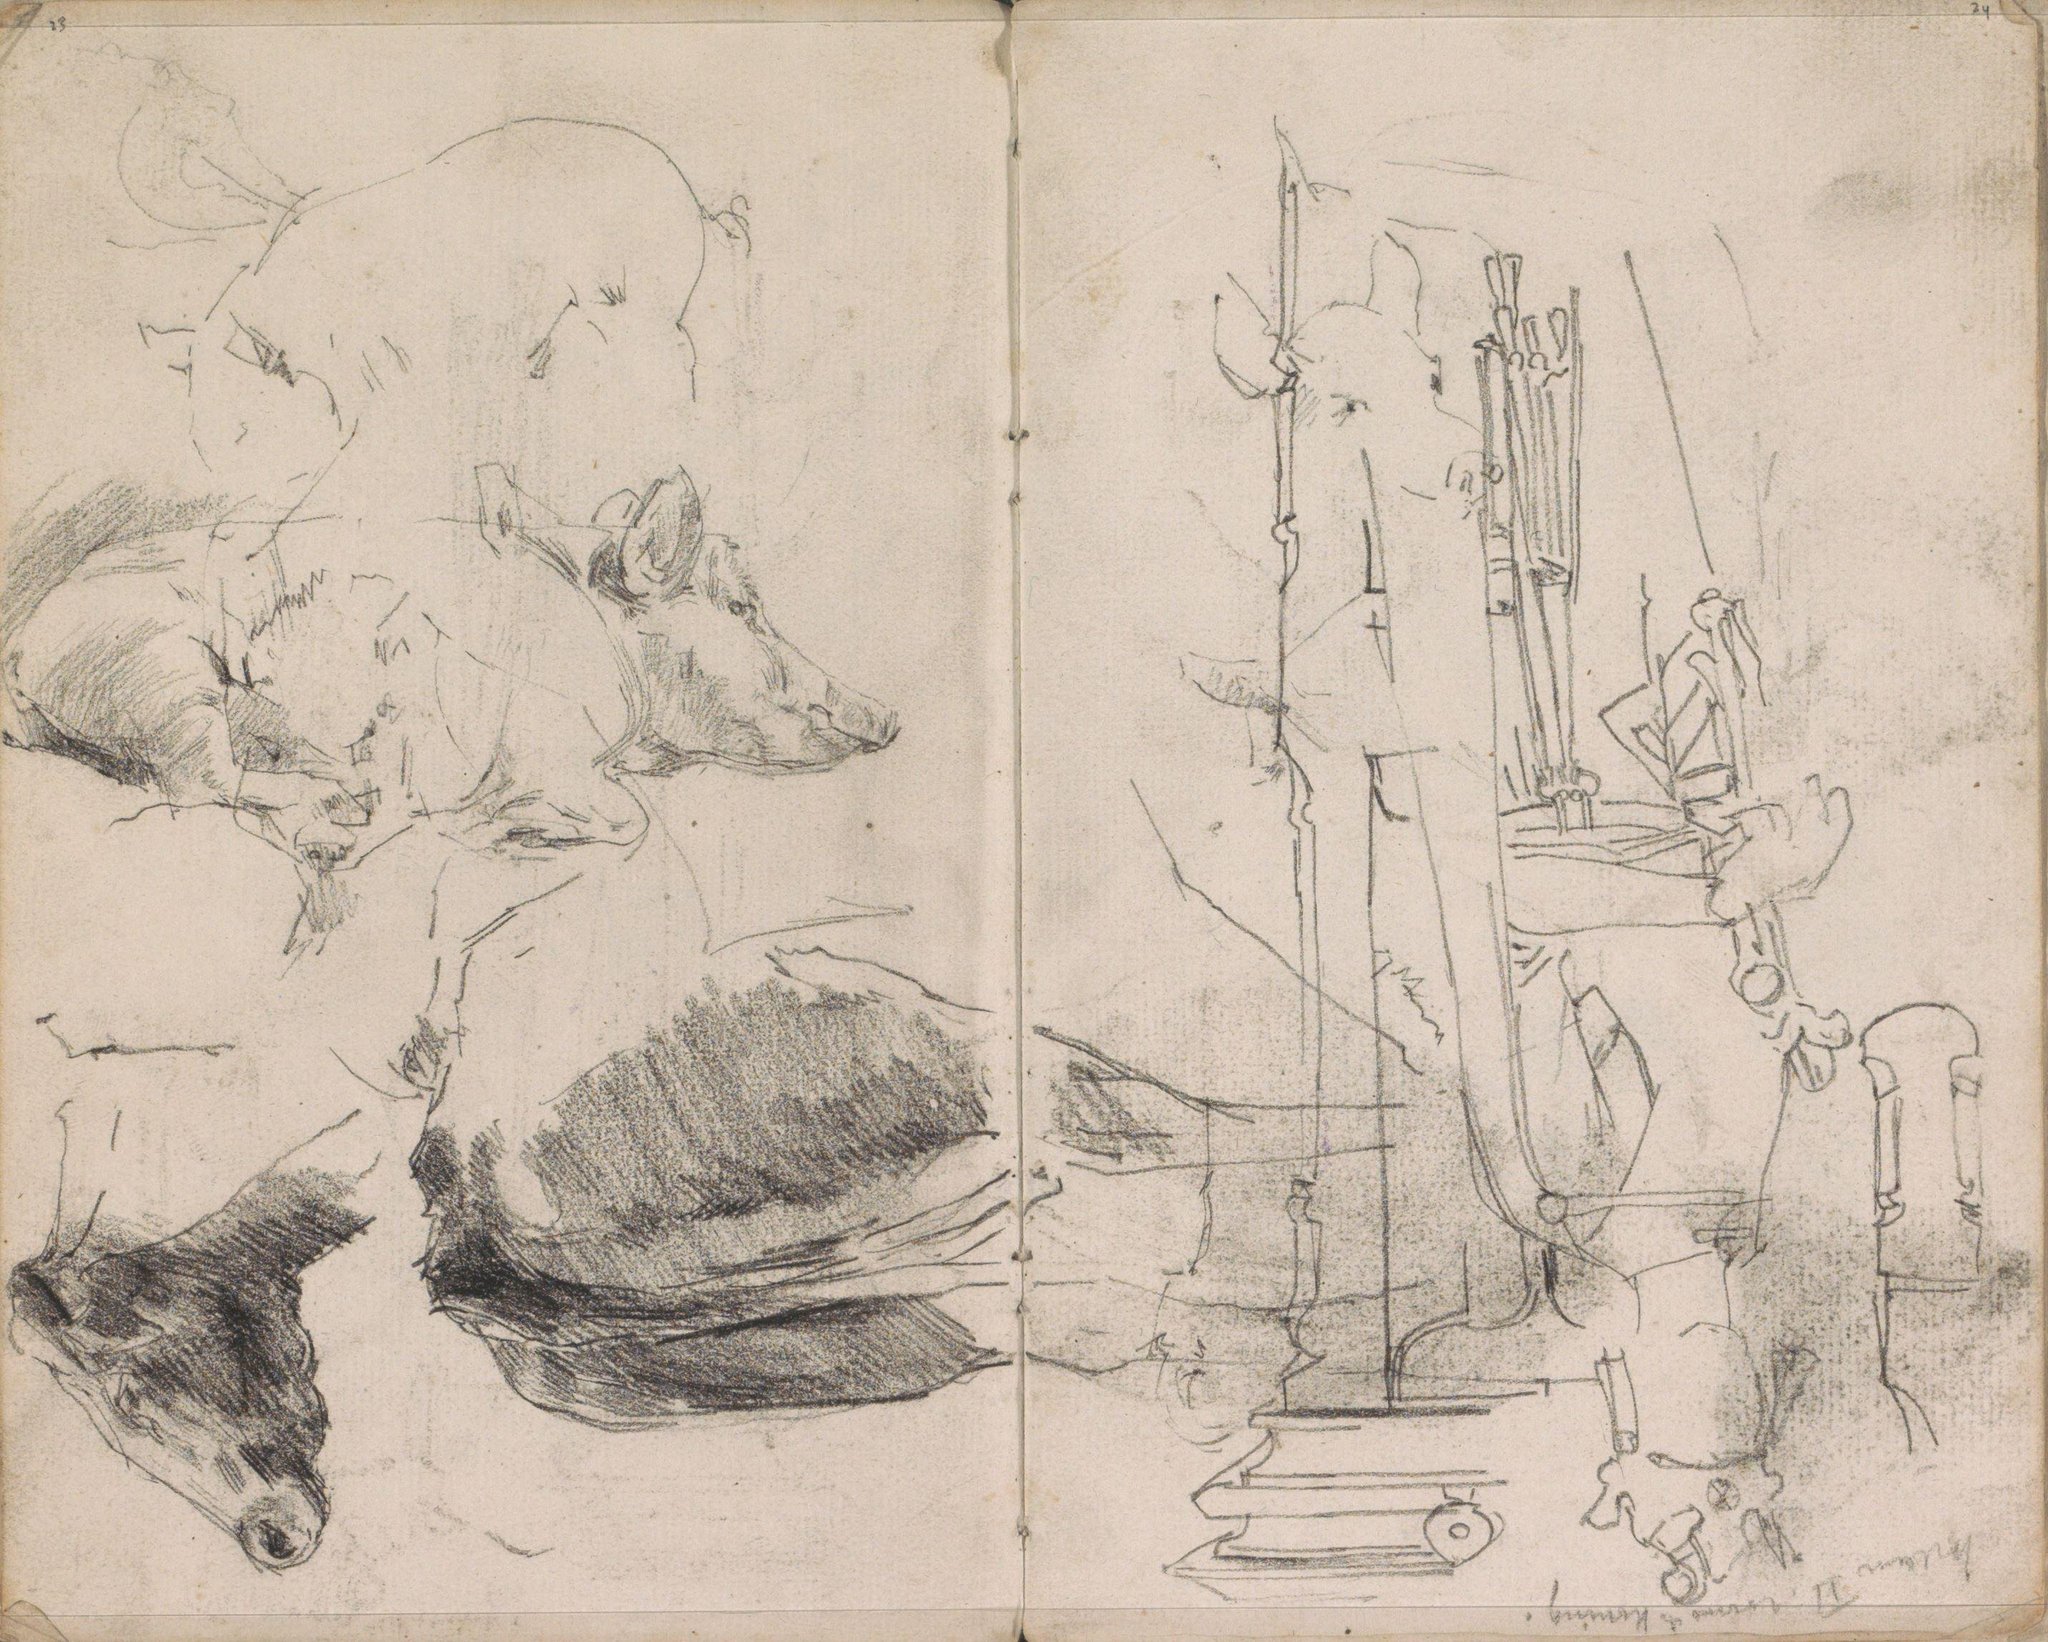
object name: sketchbook leaf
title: Studieblad met varkens, een achterlijf van een koe, architectuurstudies en een studie van Willem II van Holland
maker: george hendrik breitner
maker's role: draughtsman, painter, print maker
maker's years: 1857-1923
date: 1880-1882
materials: chalk, paper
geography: the hague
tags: pig, cow, architectural detail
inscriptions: annotation: ‘Willem II roomsche koning.’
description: Pagina 23 en pagina 24 uit een schetsboek met 29 bladen.